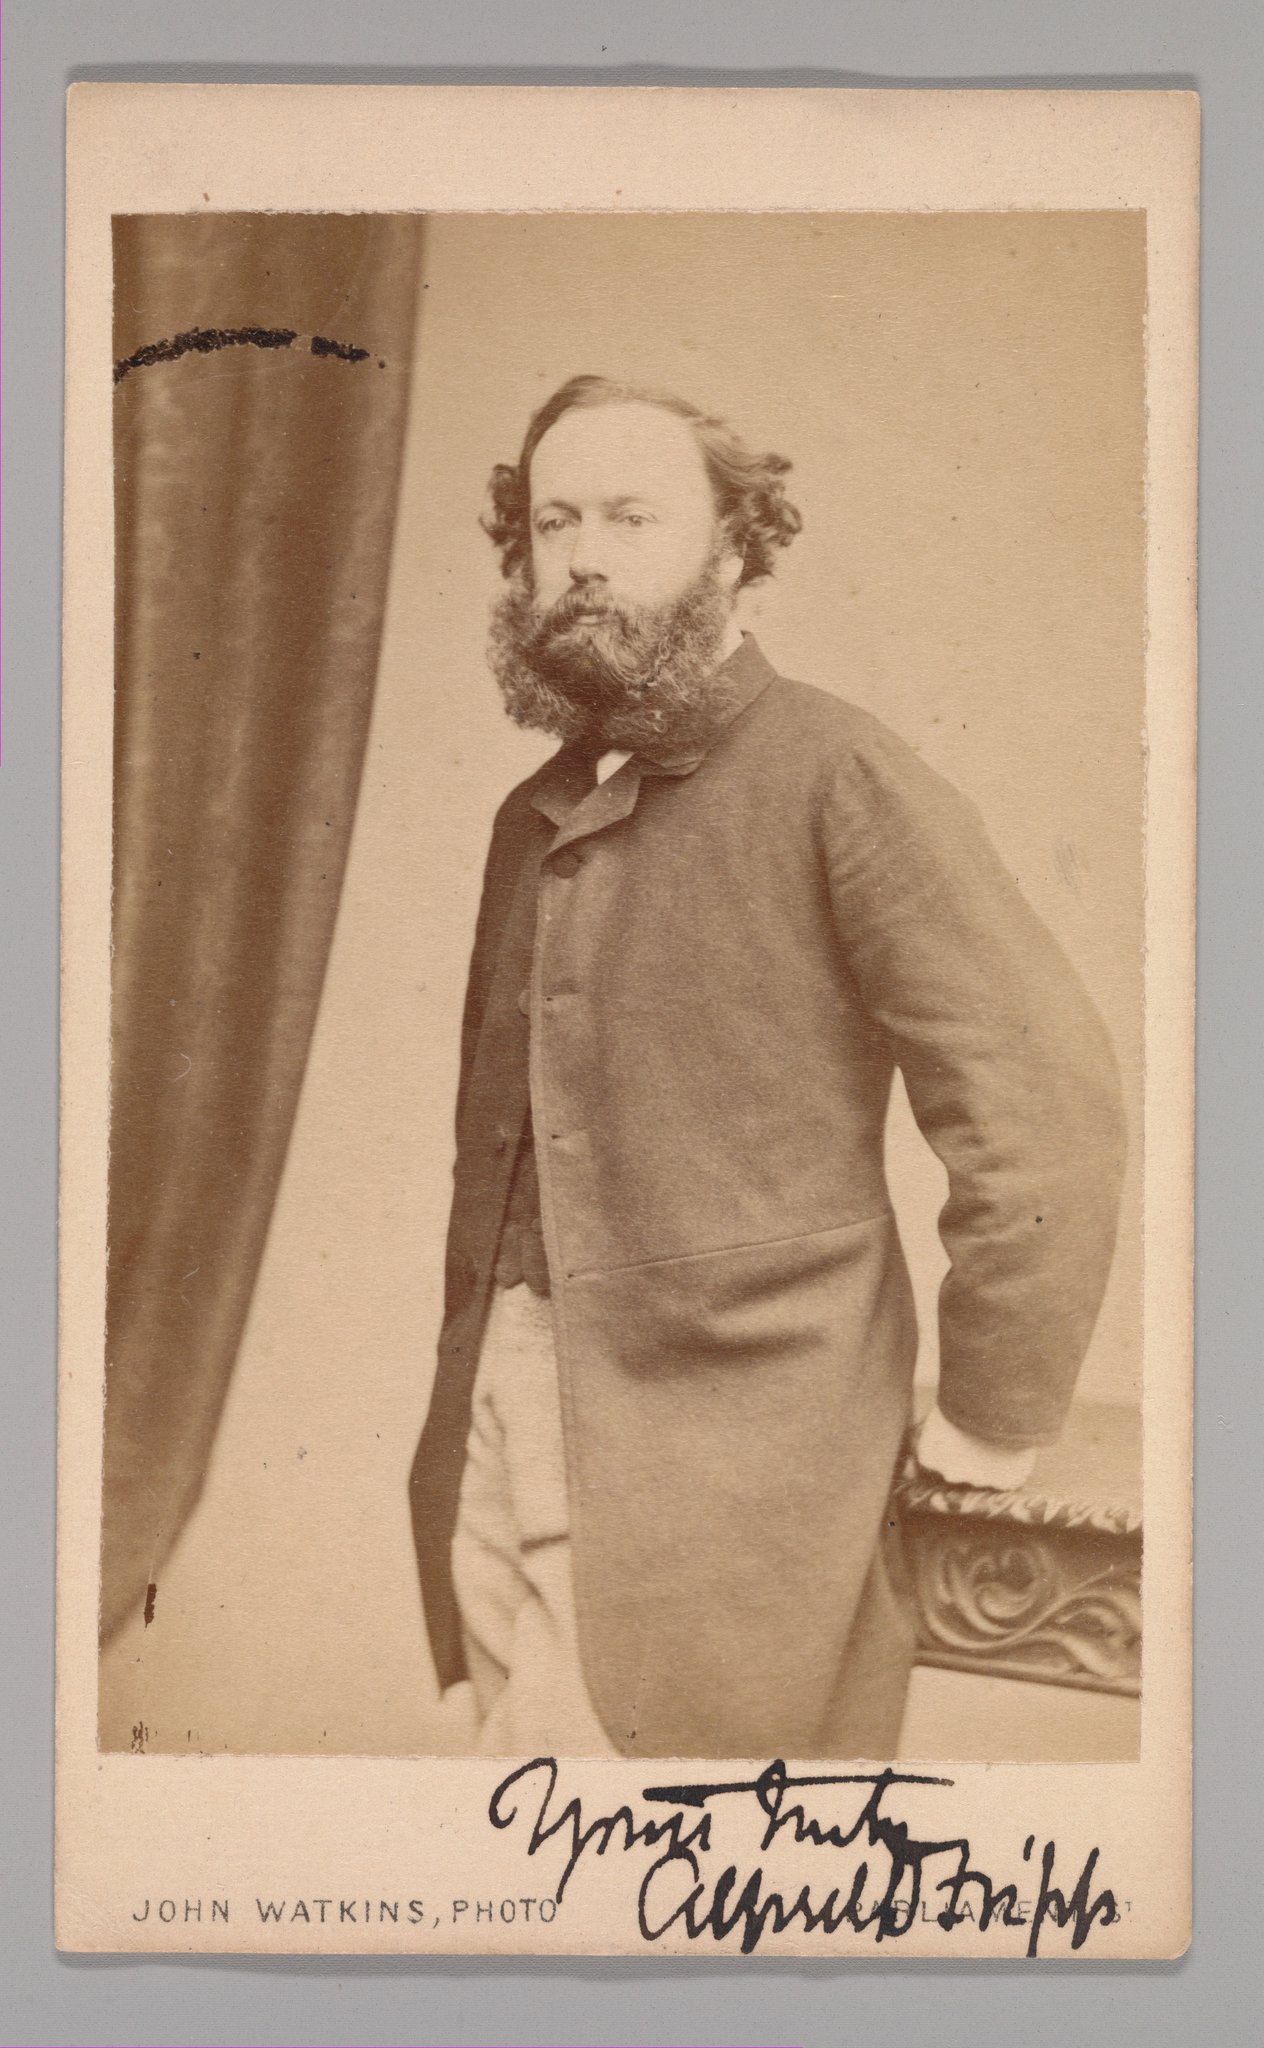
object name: carte de visite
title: [Alfred Downing Fripp]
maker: john and charles watkins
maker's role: photography studio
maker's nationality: british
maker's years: 1840-1875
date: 1860-1869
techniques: albumen silver print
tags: men,portraits